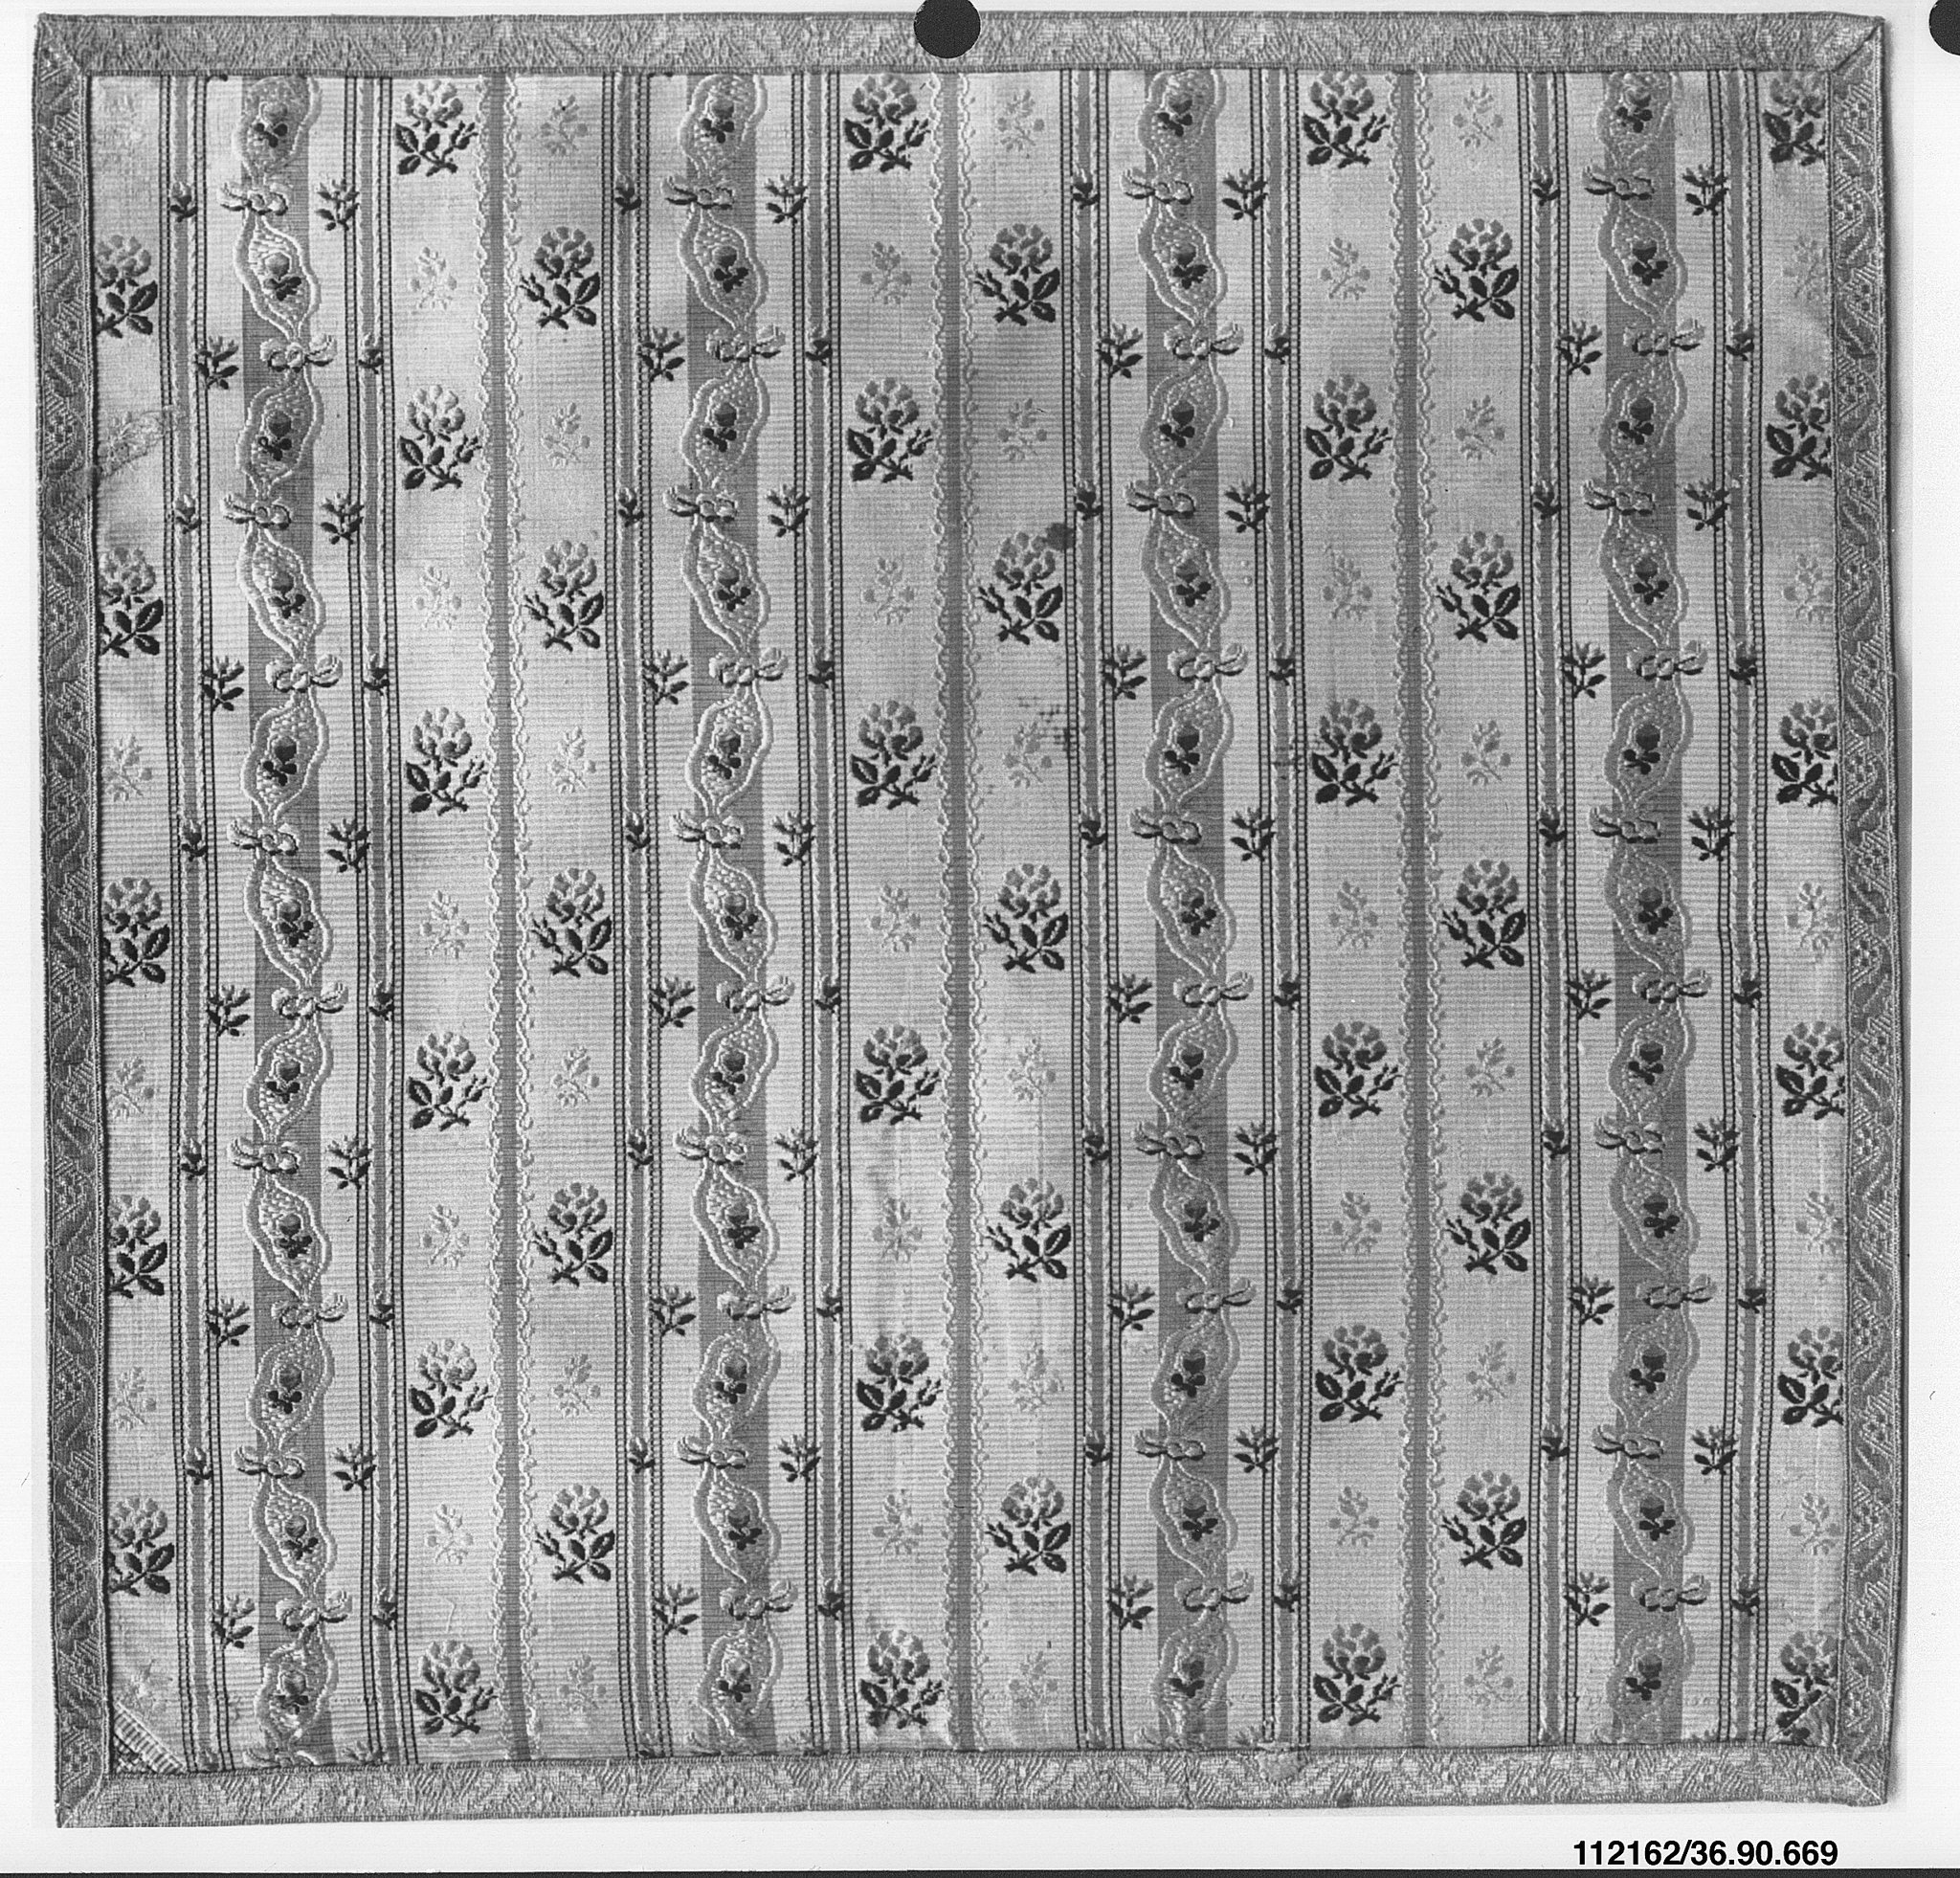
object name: piece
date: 1701-1800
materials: silk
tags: flowers